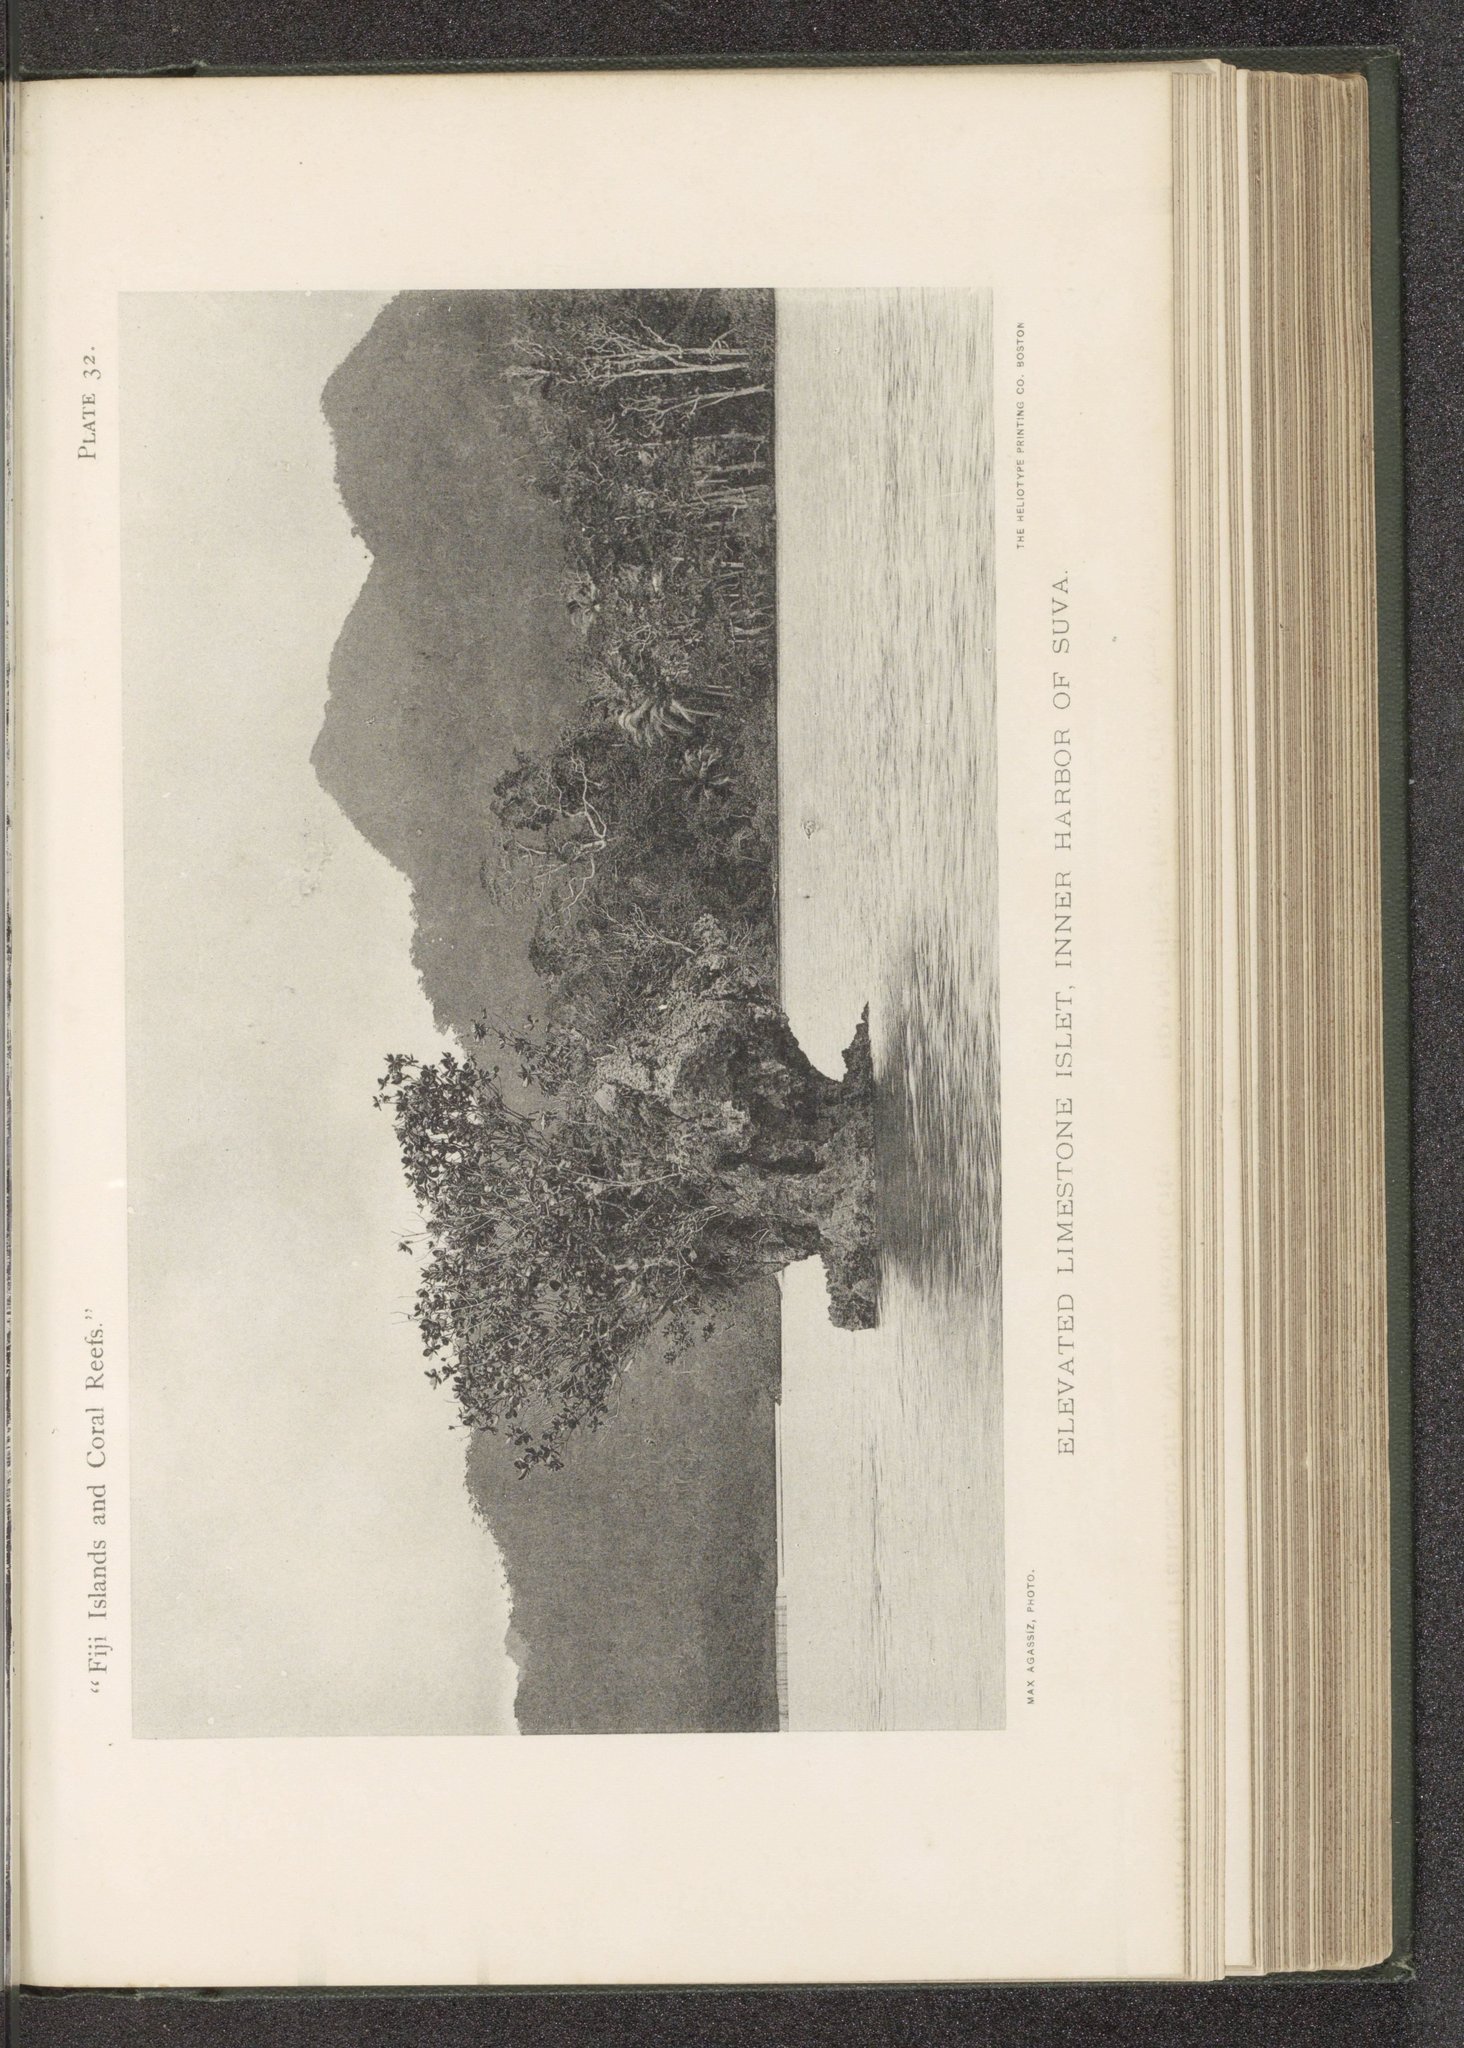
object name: page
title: Elevated limestone islet, inner harbor of Suva.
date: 1885-1899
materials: paper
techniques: photograph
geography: boston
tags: harbour, island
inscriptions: number: ‘Plate 32.’, name: ‘Max Agassiz, Photo.’, name: ‘The Heliotype Printing C. Boston’